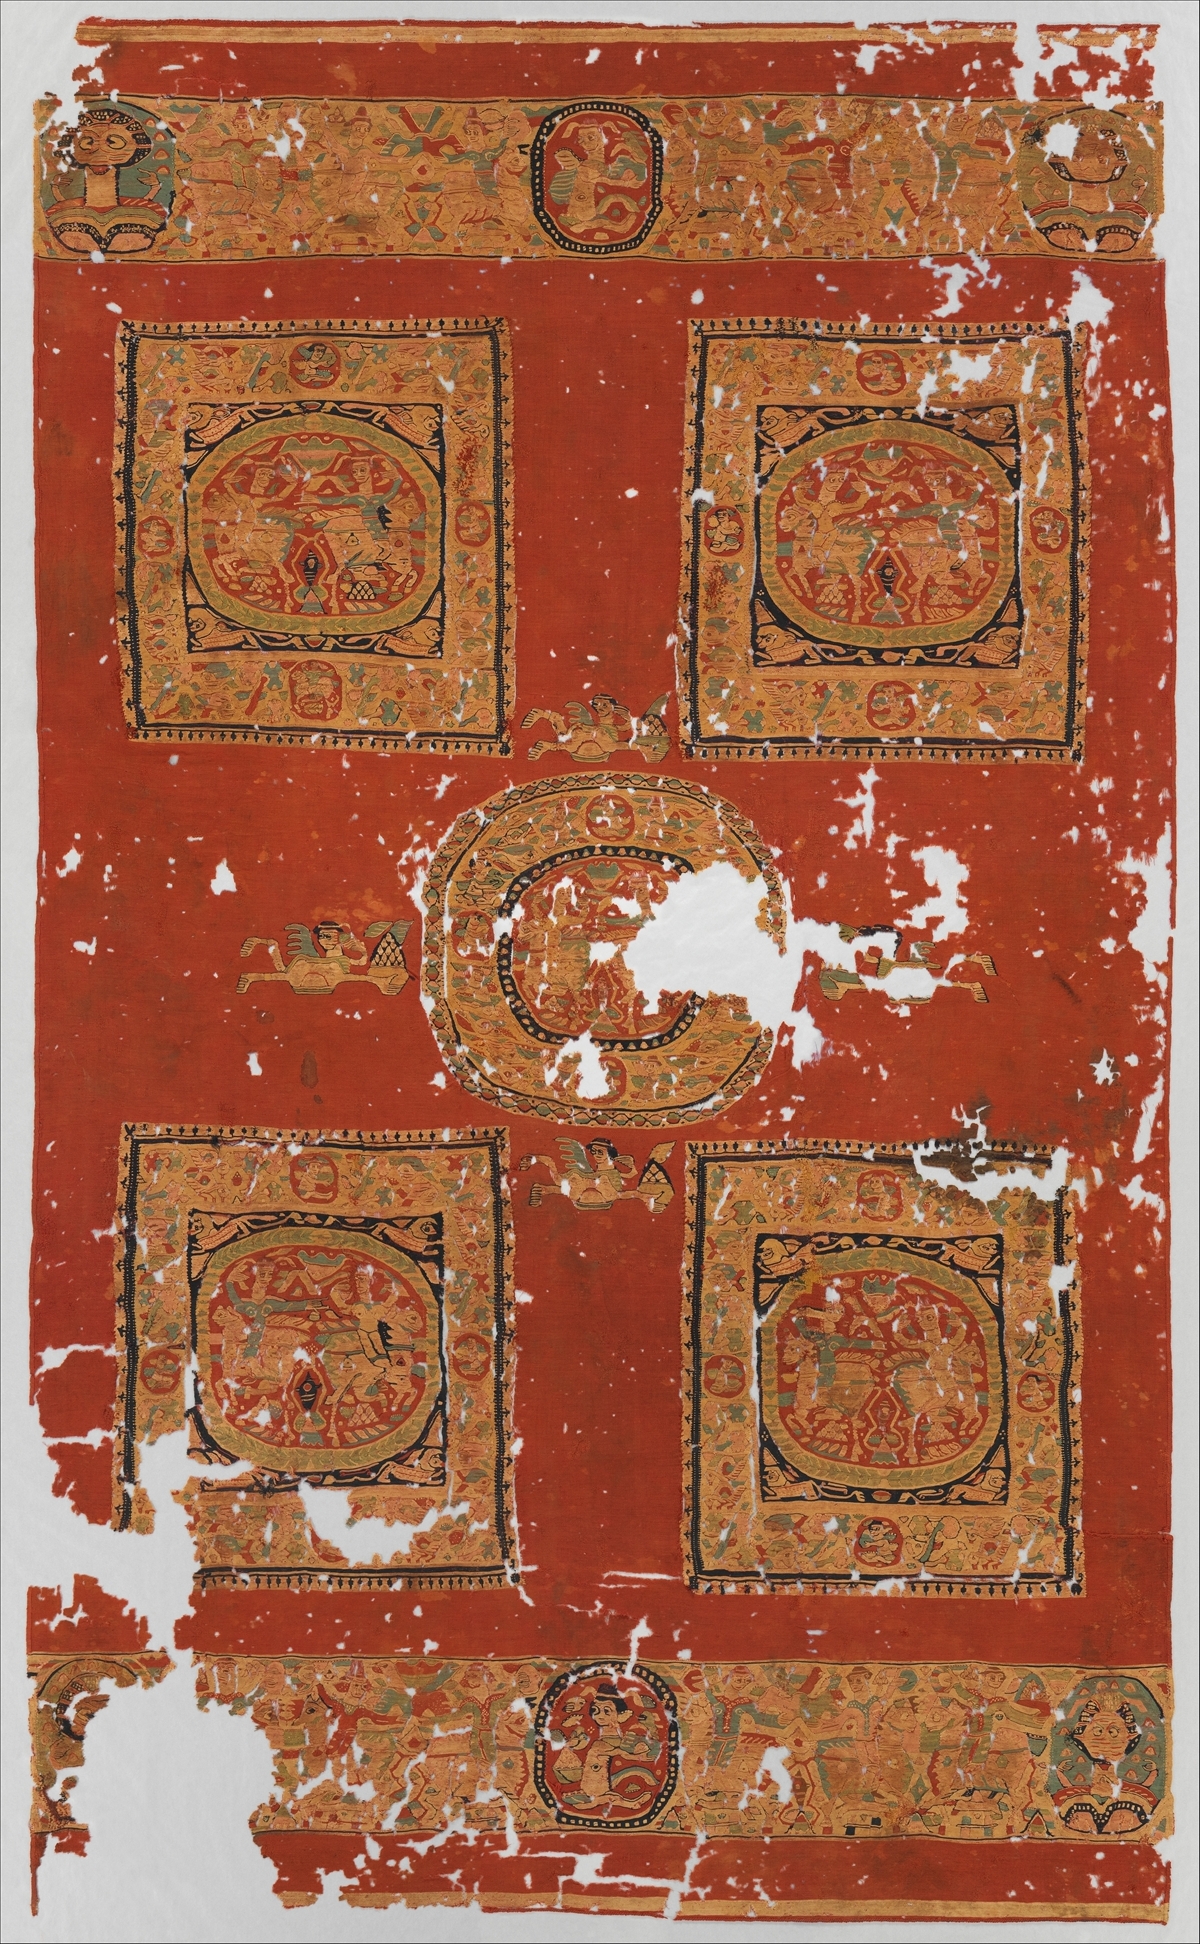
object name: hanging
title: Hanging with Images of Abundance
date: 640-660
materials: wool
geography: egypt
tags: human figures,animals